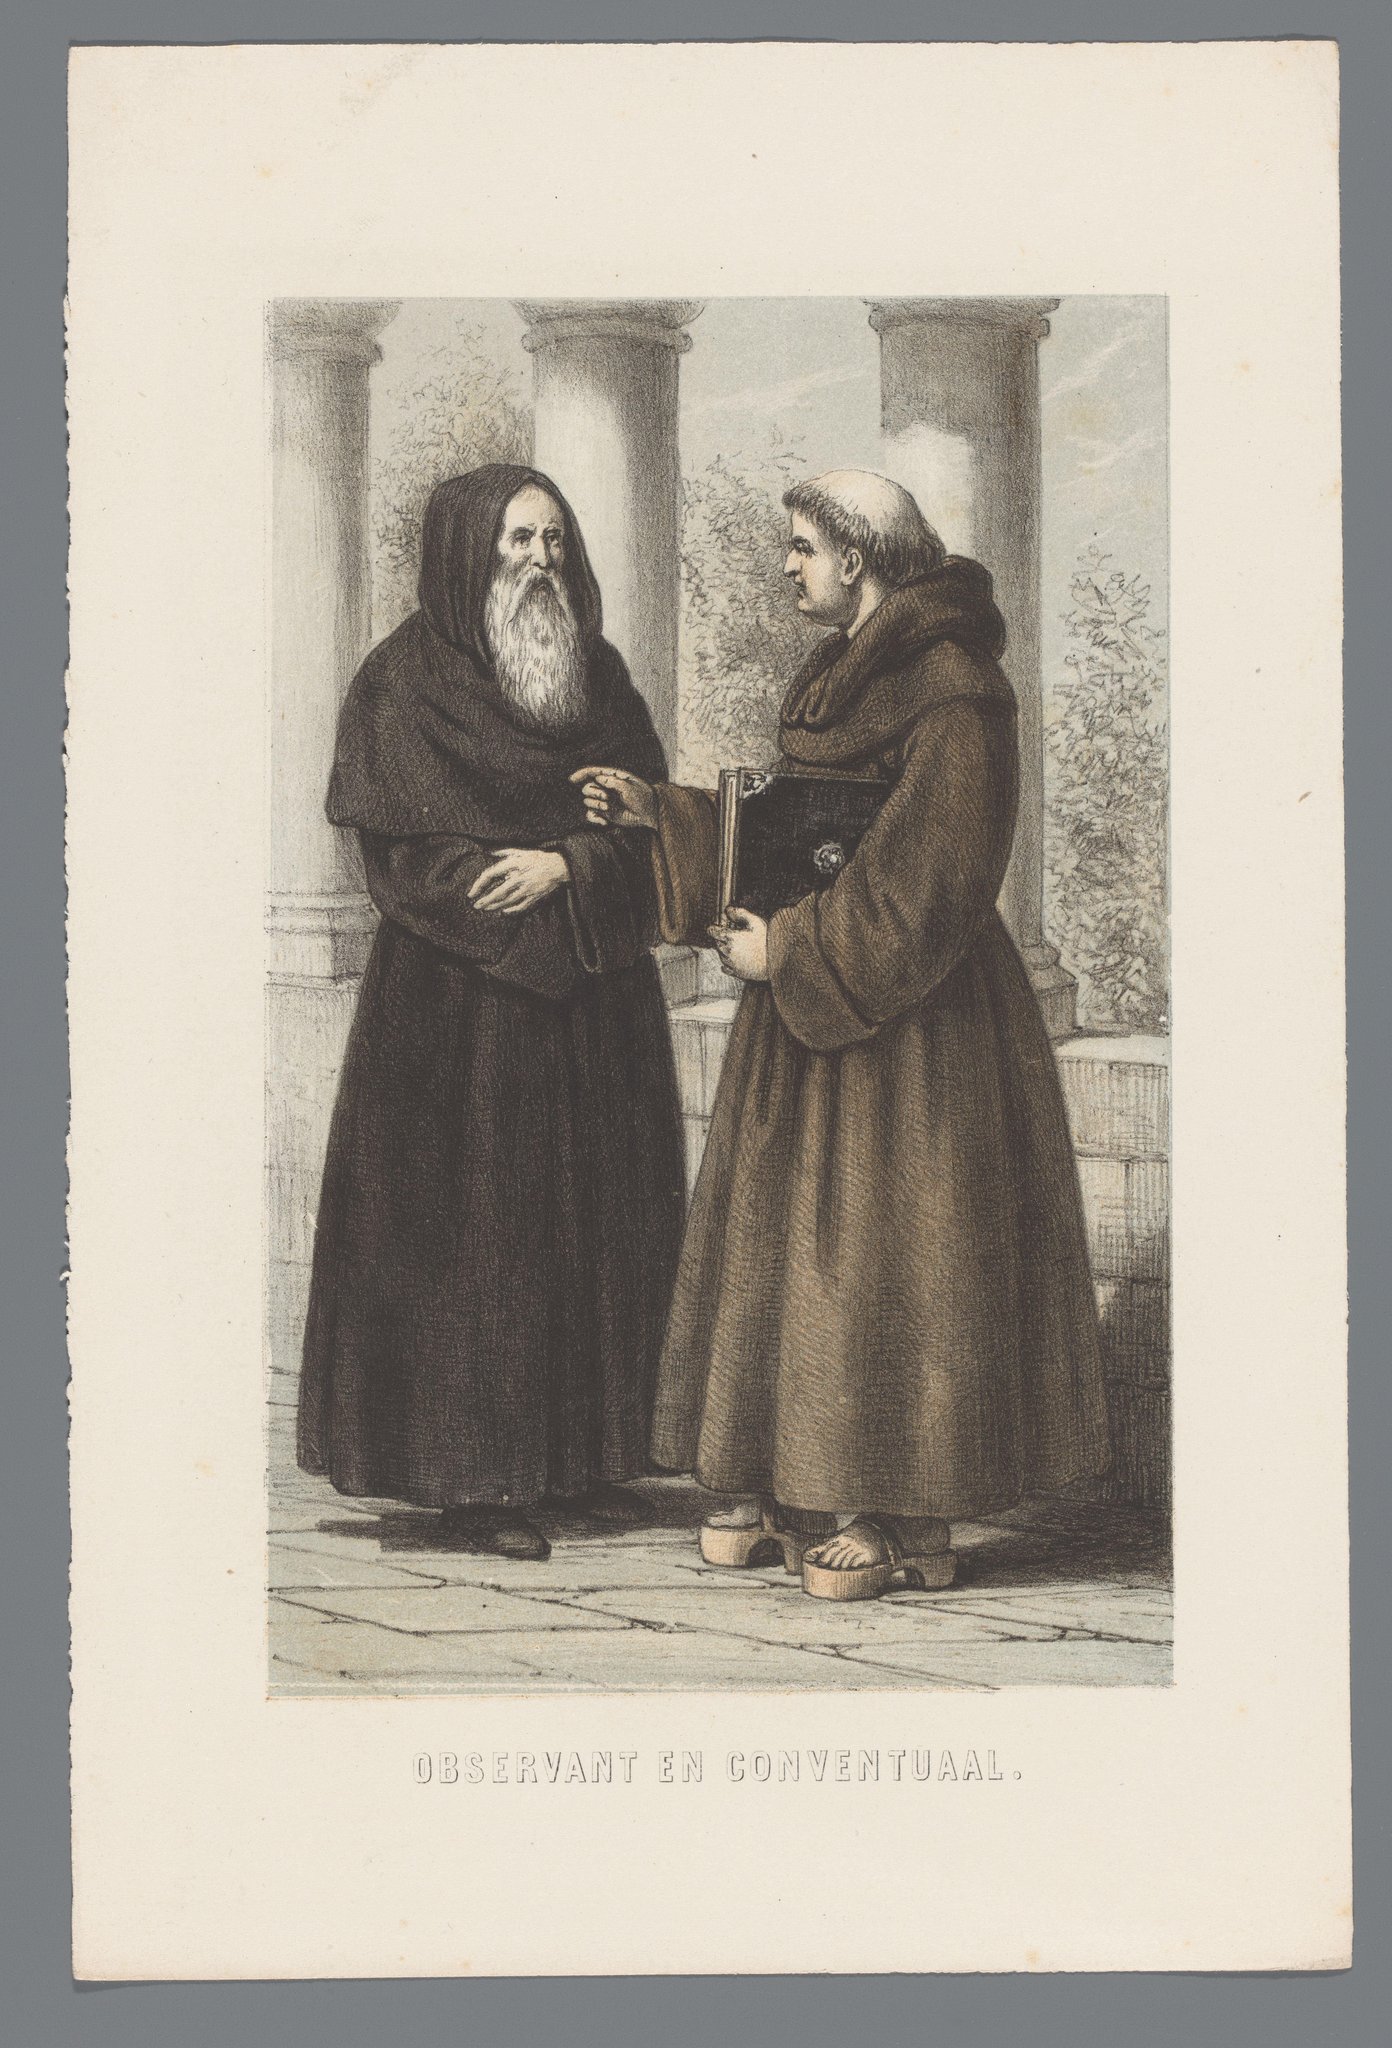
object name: book illustration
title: Observant en Conventuaal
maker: david van der kellen (1827-1895)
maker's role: draughtsman, print maker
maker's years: 1827-1895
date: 1865-1874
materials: paper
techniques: tone lithography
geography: haarlem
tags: monk(s), friar(s), monastic orders, monastic life: franciscans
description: Prent waarschijnlijk uit: Hofdijk, W.J. De klooster-orden in Nederland. Haarlem: A.C. Kruseman, 1865. Of uit de editie van 1874.